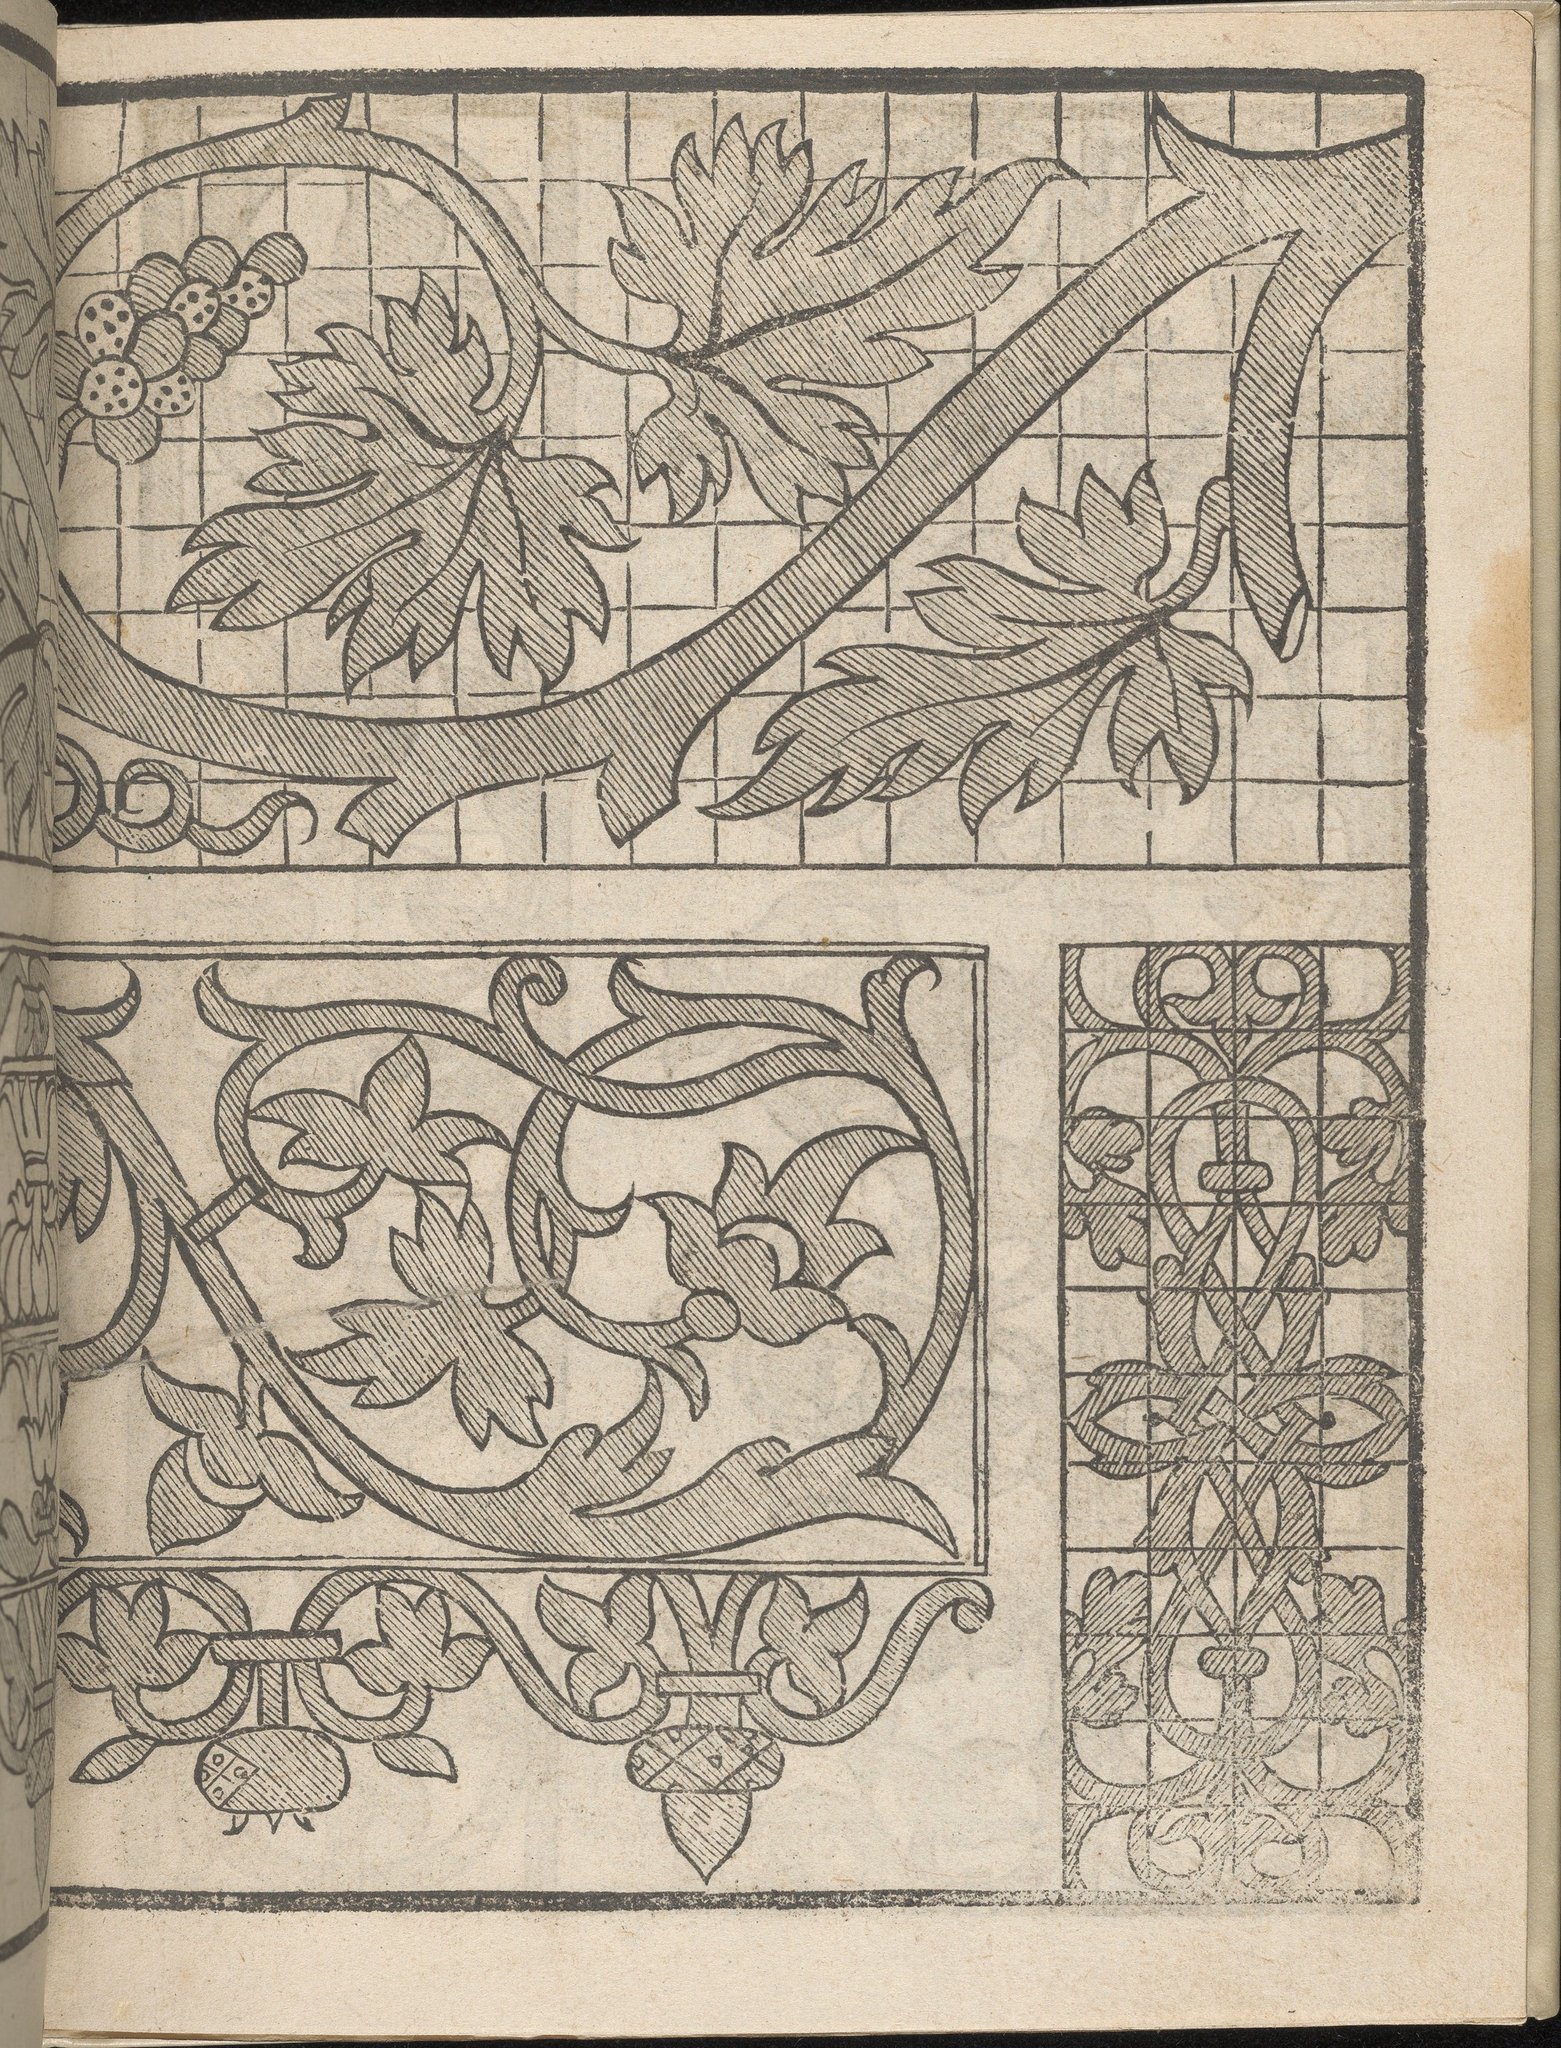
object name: book print ornament architecture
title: Lucidario di Recami, page 13 (recto)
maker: iseppo foresto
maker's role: designer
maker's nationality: italian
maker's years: 1520-1580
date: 1564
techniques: woodcut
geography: italy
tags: acorns,vines